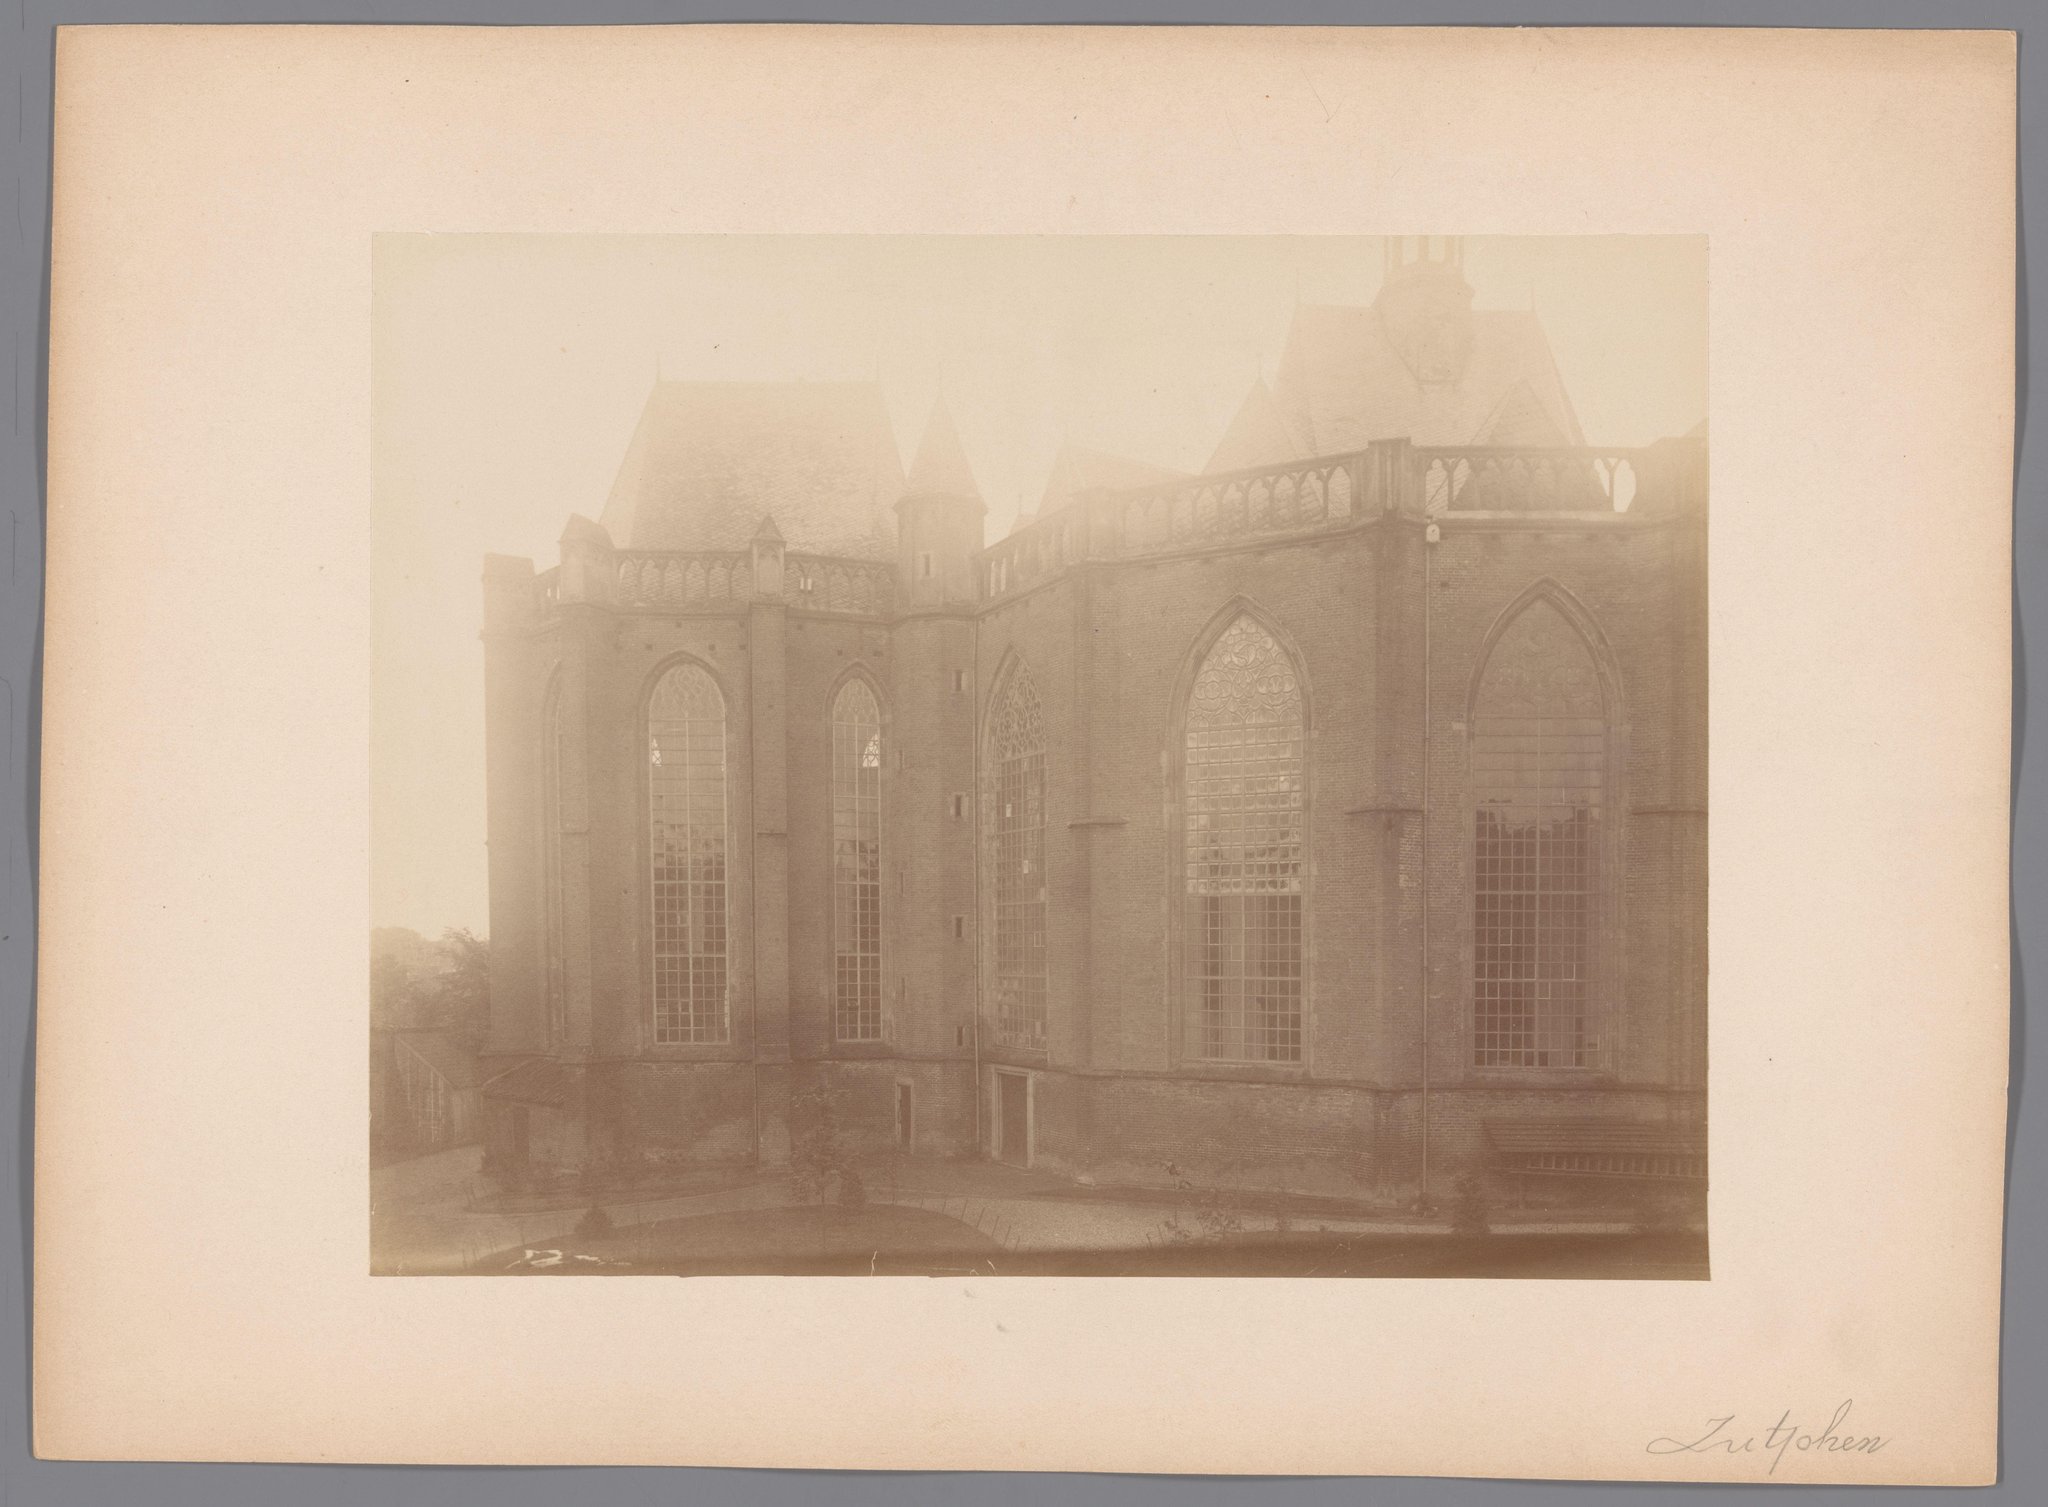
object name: photograph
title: Noordzijde van het koor van de Sint Walburgiskerk te Zutphen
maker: anoniem (monumentenzorg)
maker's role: fotograaf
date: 1890-1910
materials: cardboard, photographic support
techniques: albumen print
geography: zutphen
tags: parts of church exterior and annexes: choir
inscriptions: annotation: ‘Zutphen’, annotation: ‘Zutphen/ Noordaanzicht van het koorgedeelte van de Ned. Herv. Kerk’